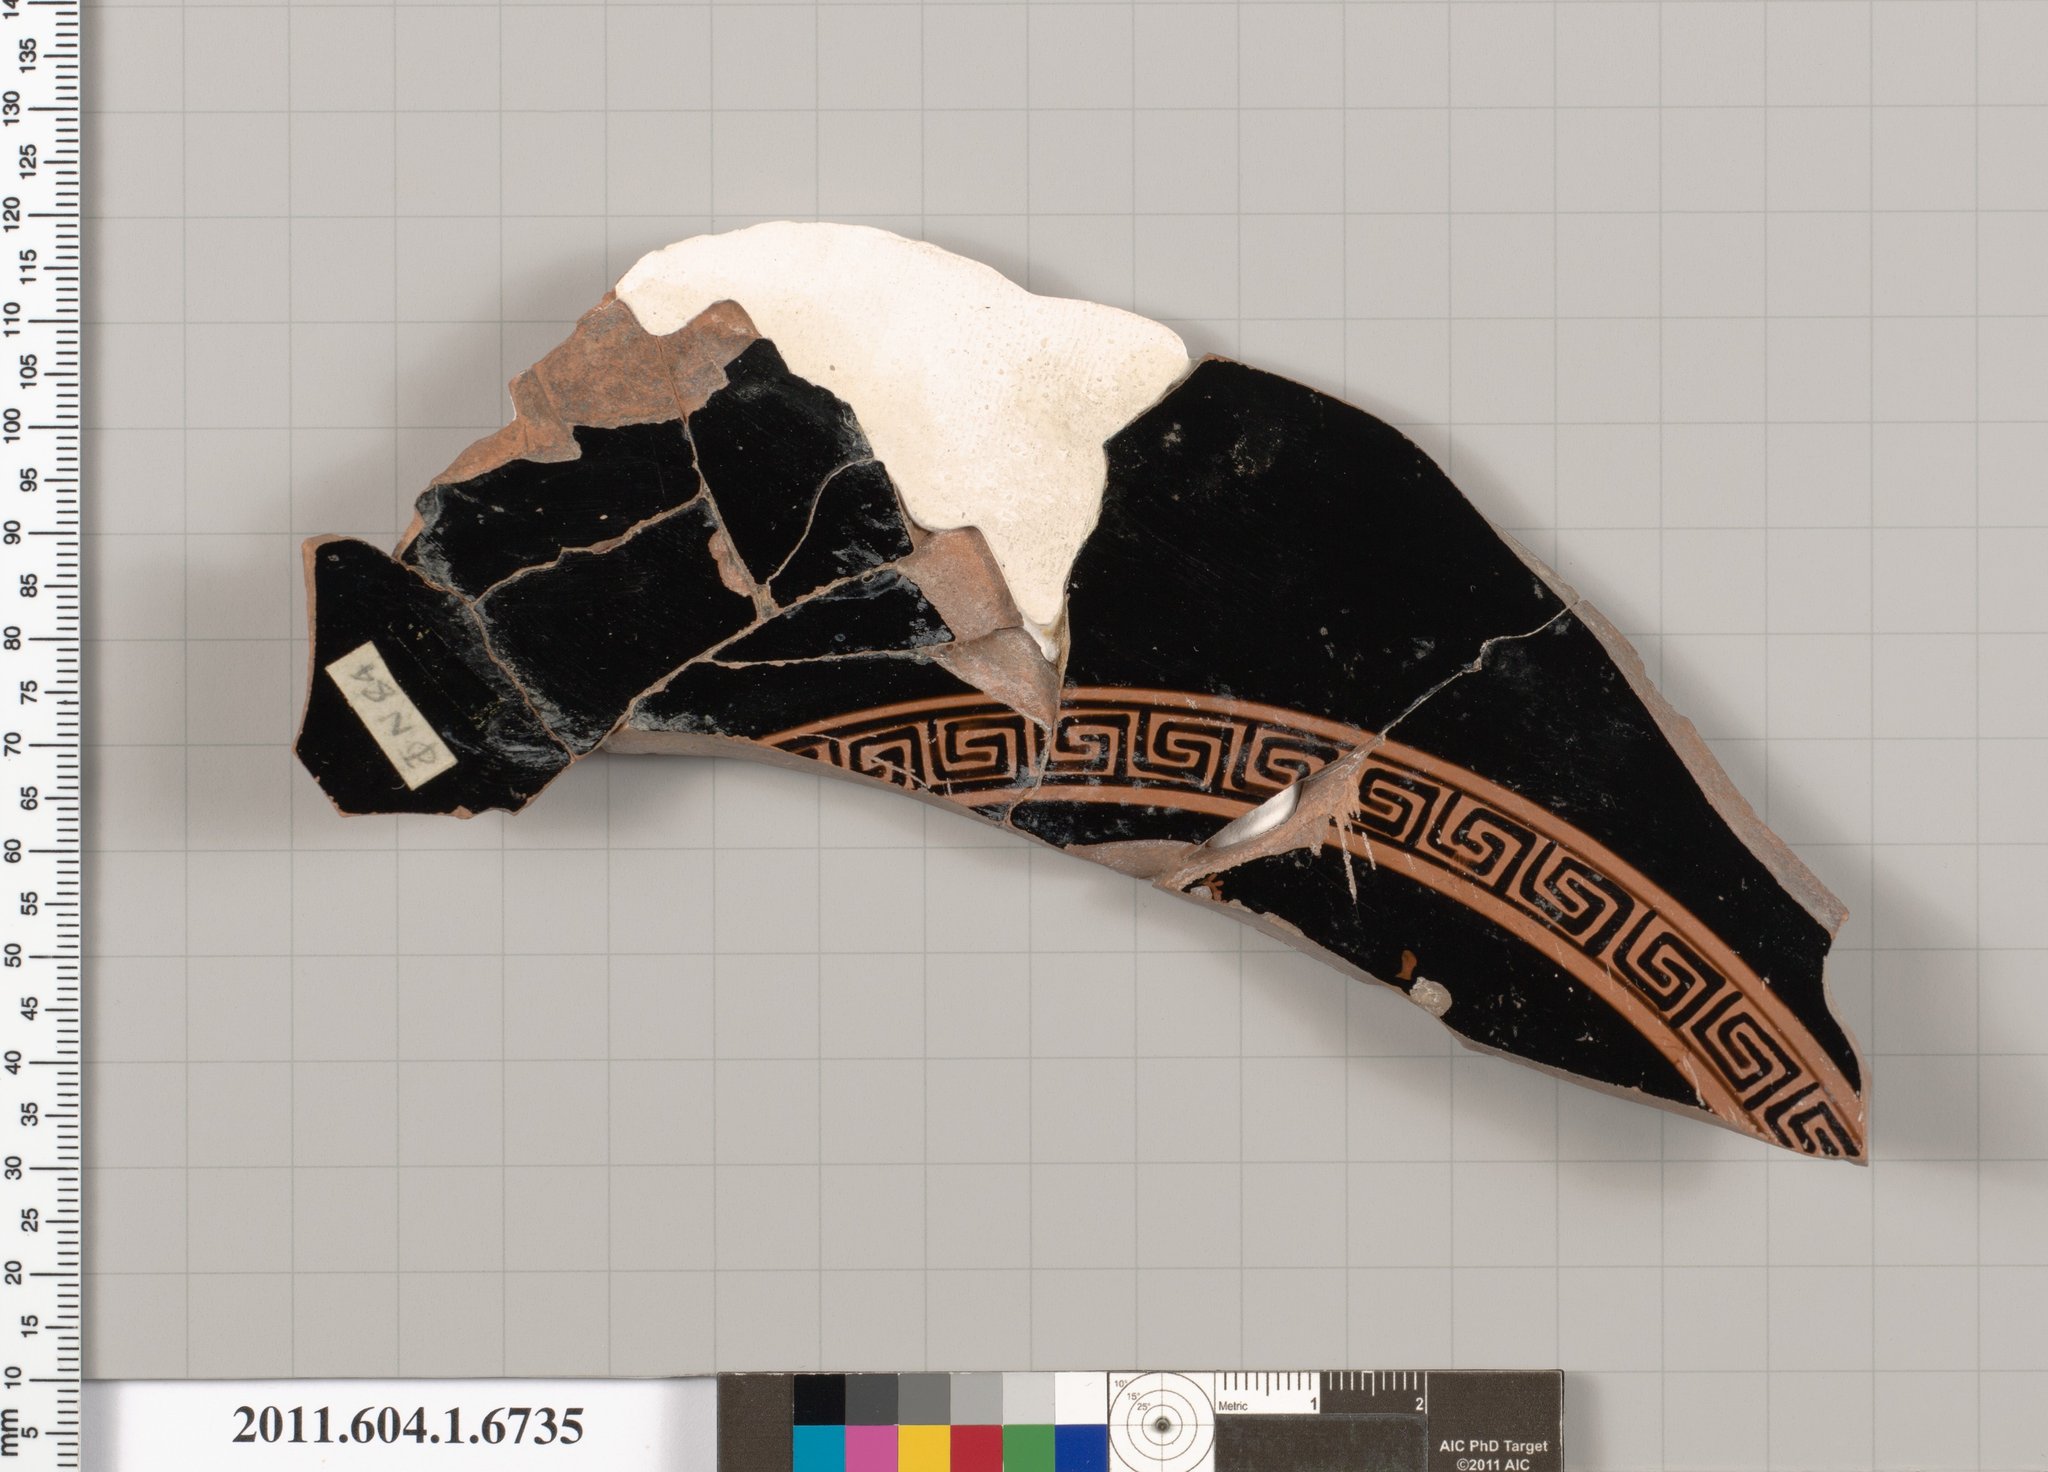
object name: kylix fragment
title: Terracotta fragment of a kylix (drinking cup)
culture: greek, attic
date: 490-470 BCE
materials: terracotta